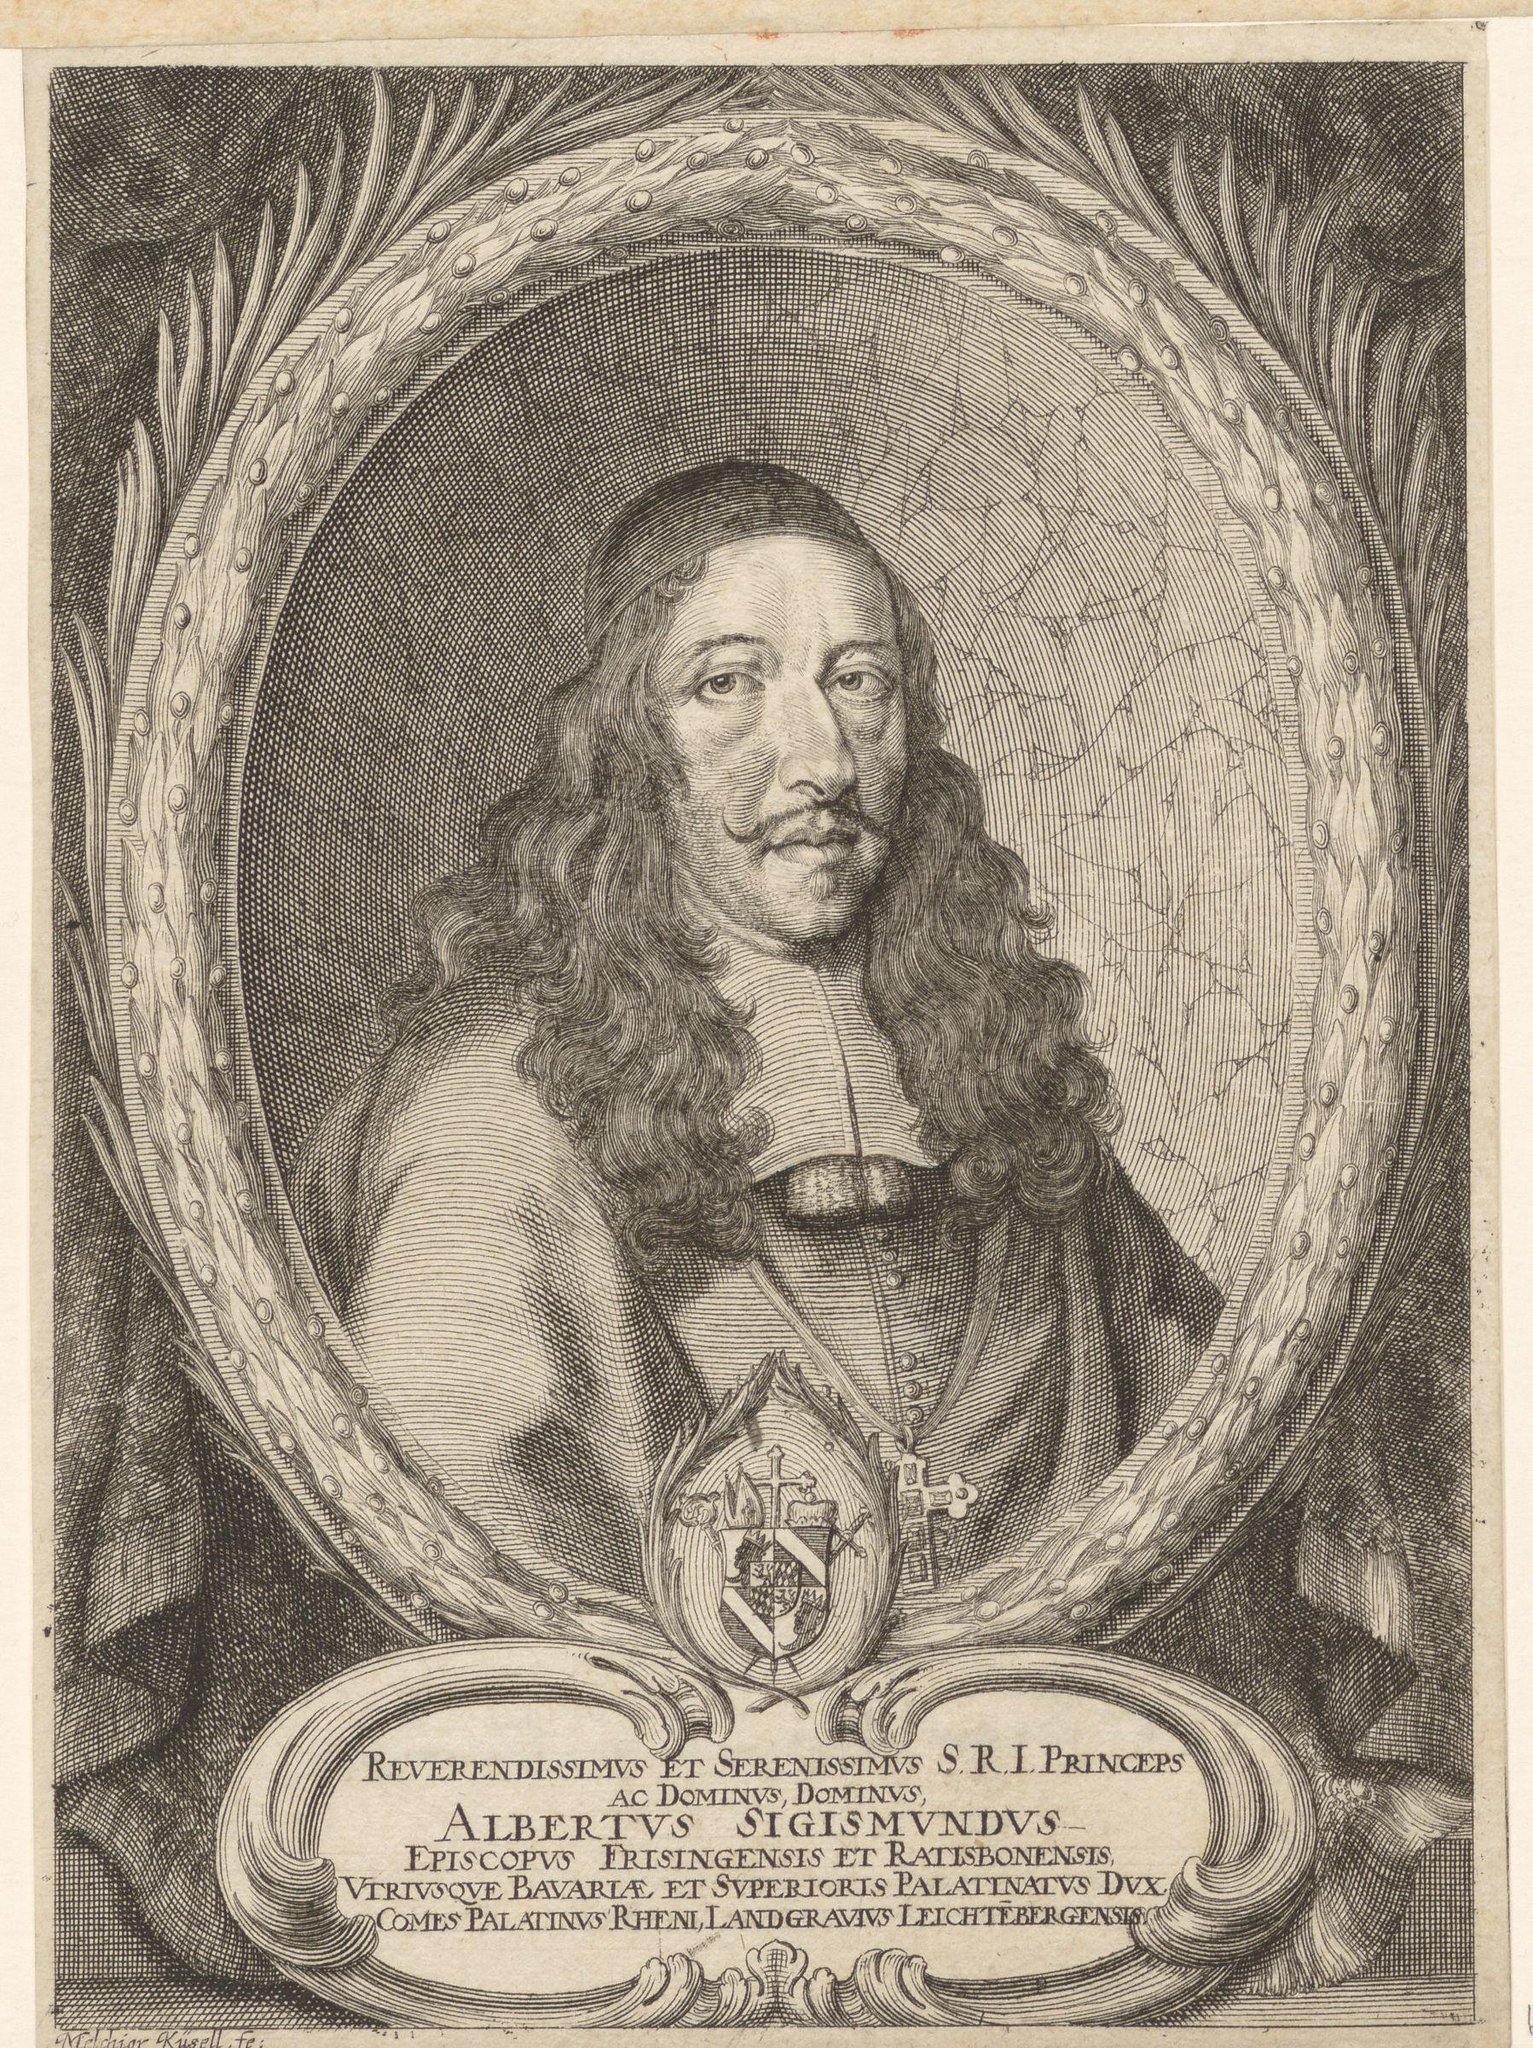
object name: print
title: Portret van Albert Sigmund von Beieren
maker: melchior küsel (i)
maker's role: print maker, publisher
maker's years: 1626-1683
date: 1636-1683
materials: paper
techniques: engraving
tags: archbishop, bishop, etc. (roman catholic), historical persons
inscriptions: collector's mark: Lugt 2228